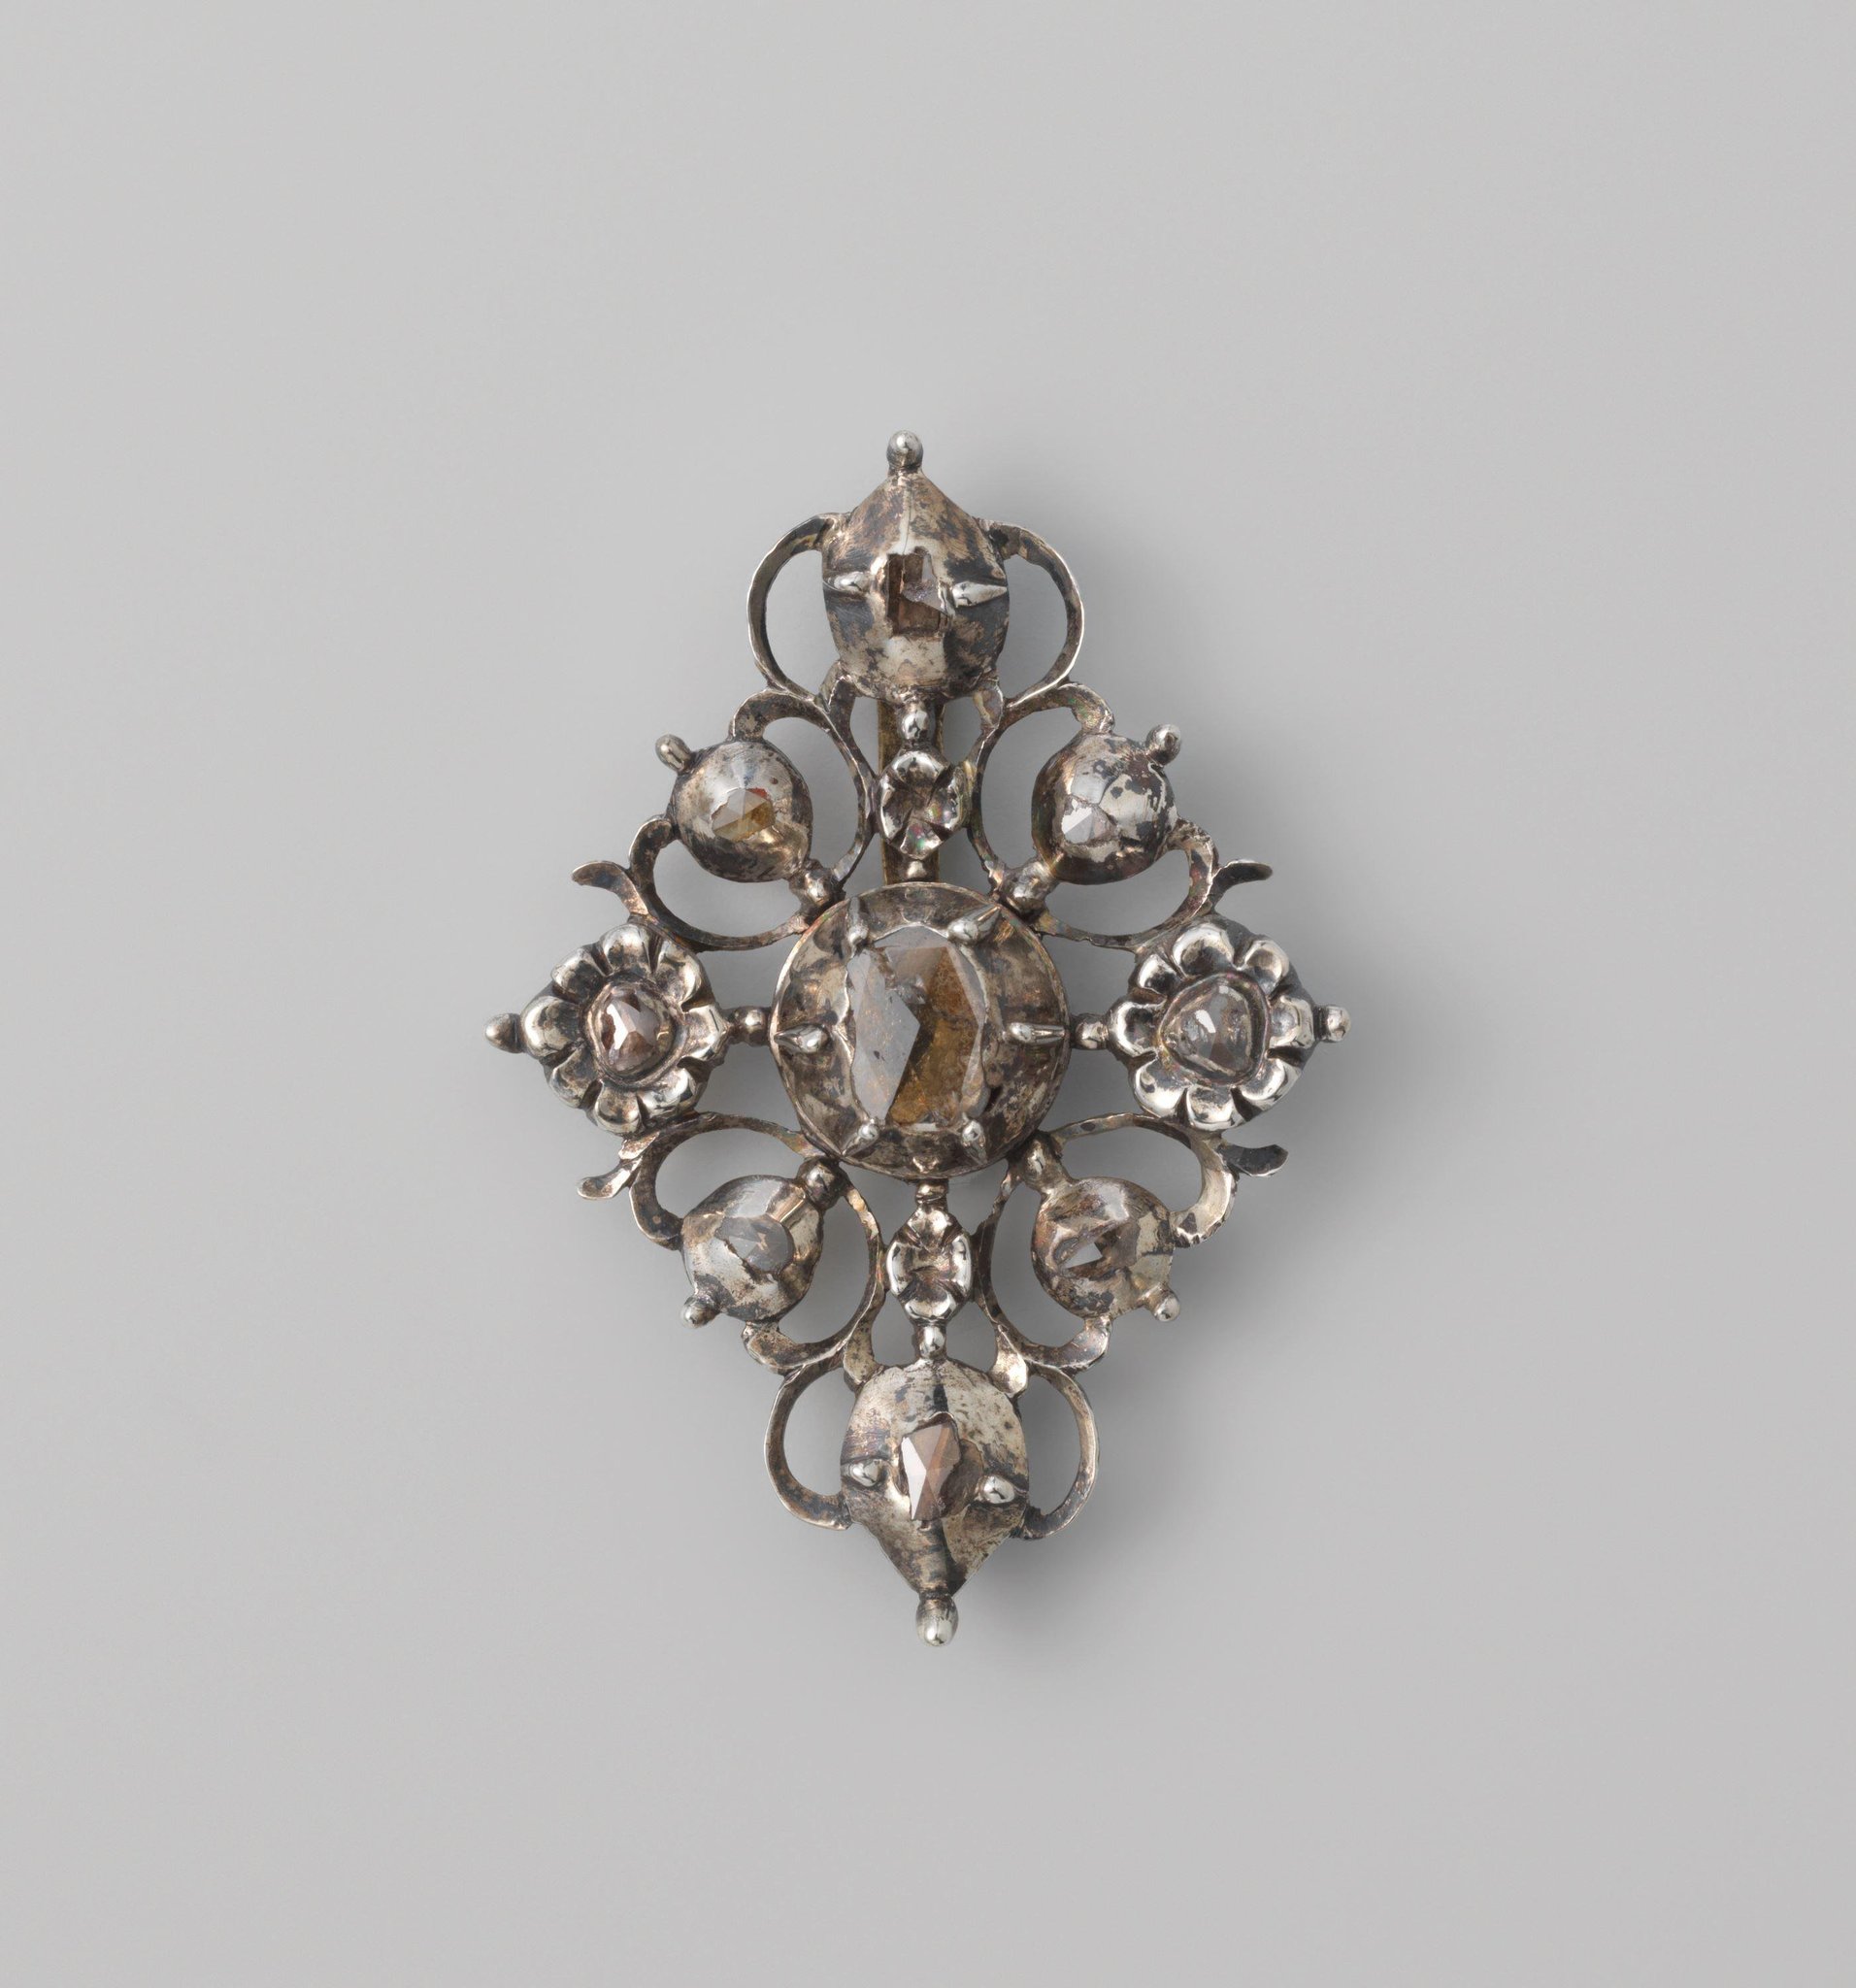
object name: streeksieraad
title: Slot van een (streek)sieraad bezet met diamant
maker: Anonymous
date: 1650-1699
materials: diamond, silver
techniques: grinding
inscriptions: number: ‘187’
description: Juwelen ruitvormige boot met een negen diamanten, in zilver gezet. De centrale diamant is een platte roos, de acht kleinere diamanten splinters zijn allen van enkele facetten voorzien. Op de achterzijde staat '187' gegraveerd. De achterzijde is voorzien van een gouden schuifje met daar tegenover de restanten van een oorspronkelijk bevestigingspunt. Mogelijk is dit een (schuif)slot geweest van een collier.